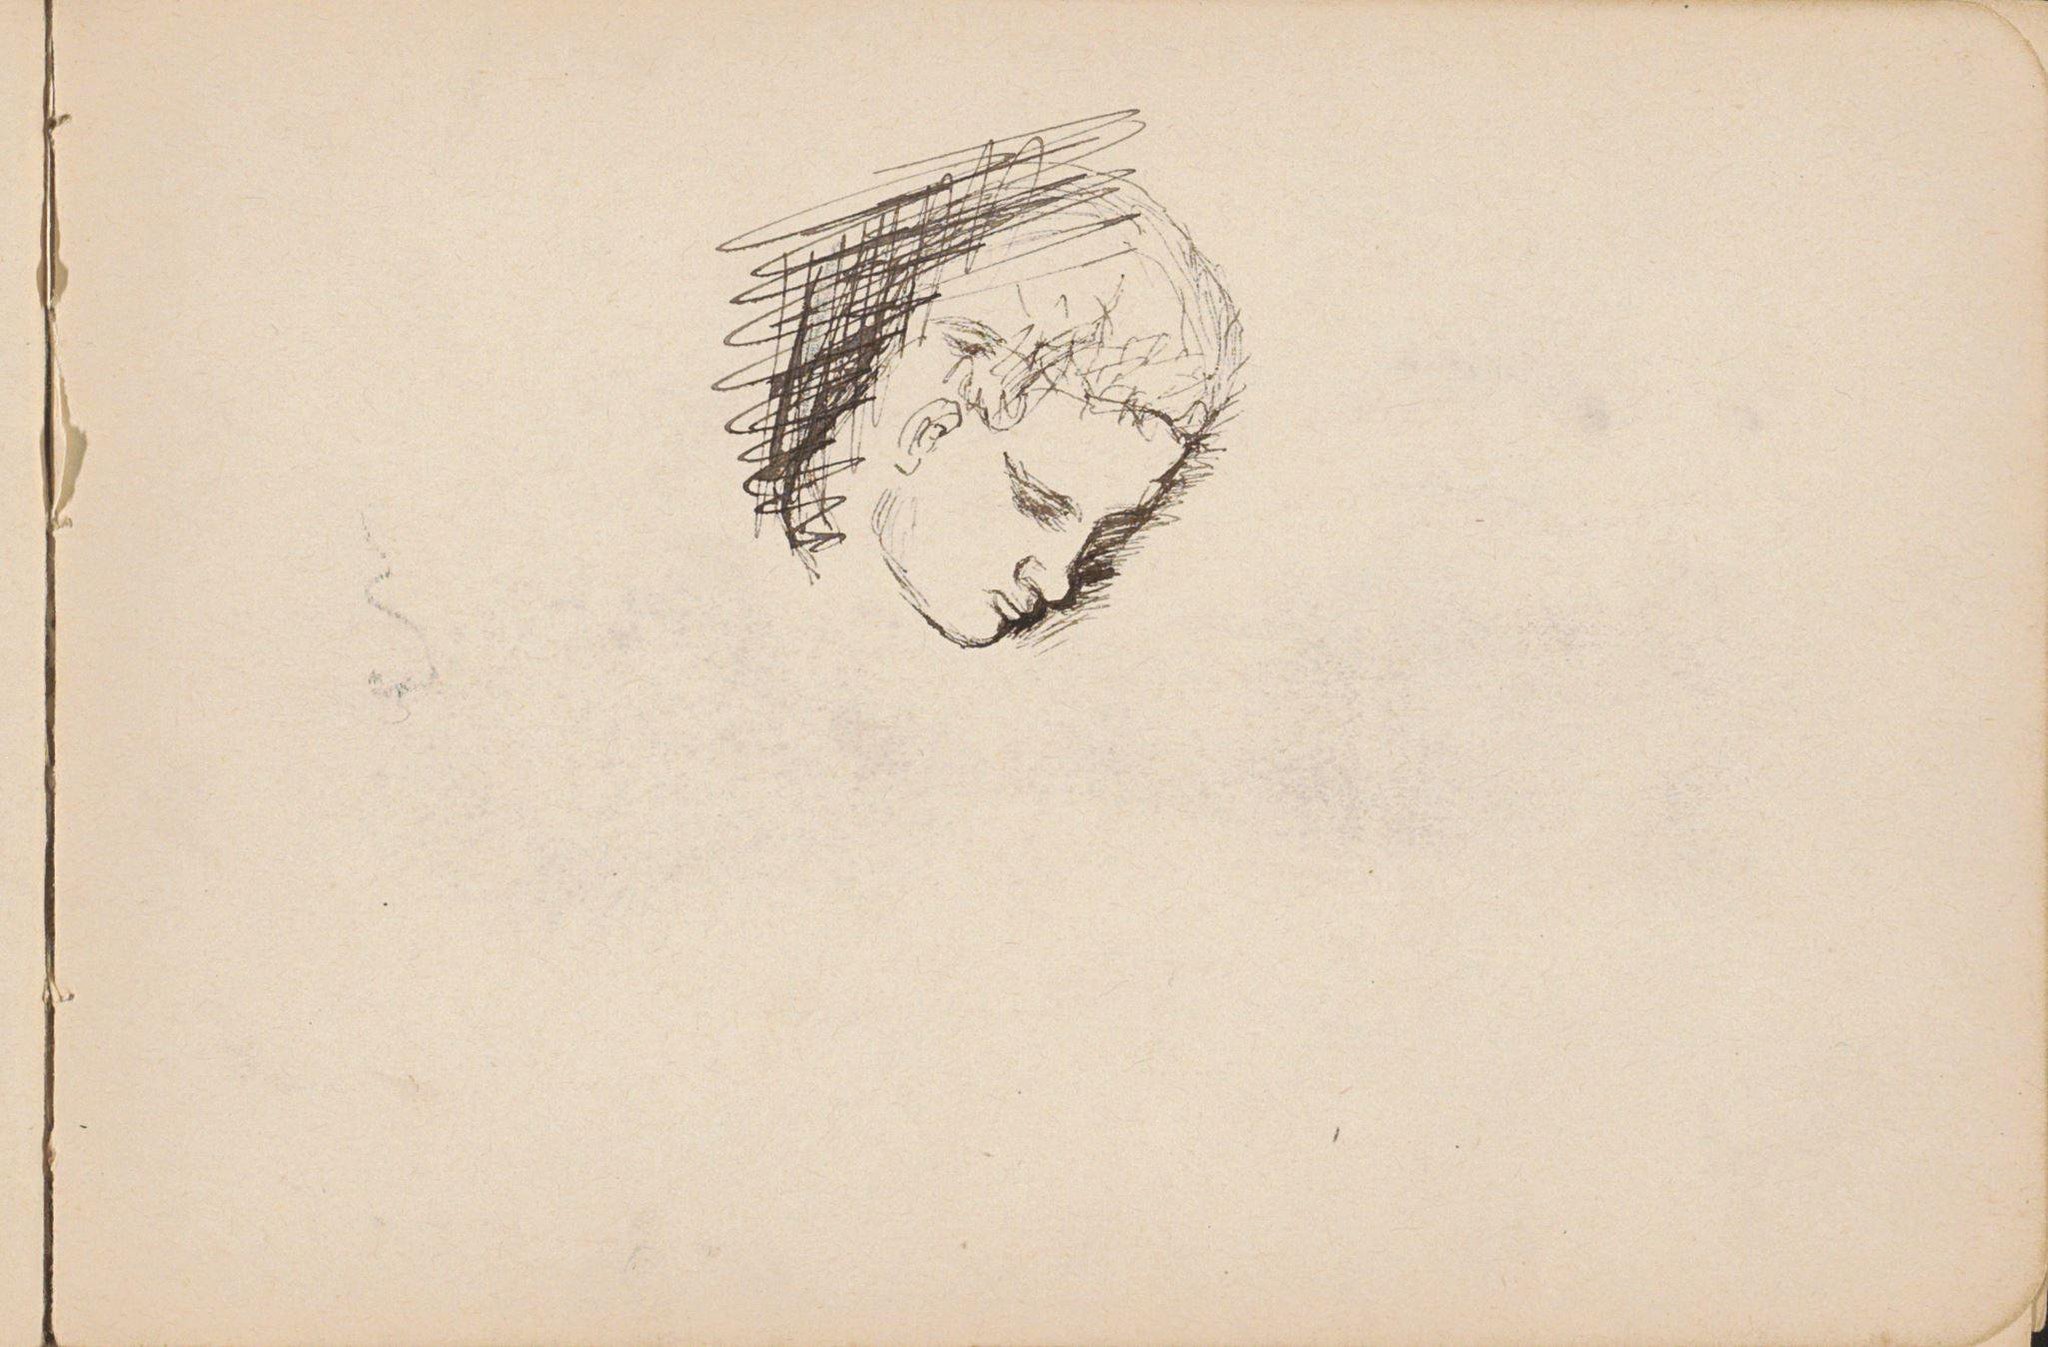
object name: sketchbook leaf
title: Kop van een man met gesloten ogen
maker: julie de graag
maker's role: draughtsman, print maker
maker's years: 1877-1924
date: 1894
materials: ink, paper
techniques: pen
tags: head (human), adult man, eyes closed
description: Blad 35 recto uit een schetsboek met 35 bladen.